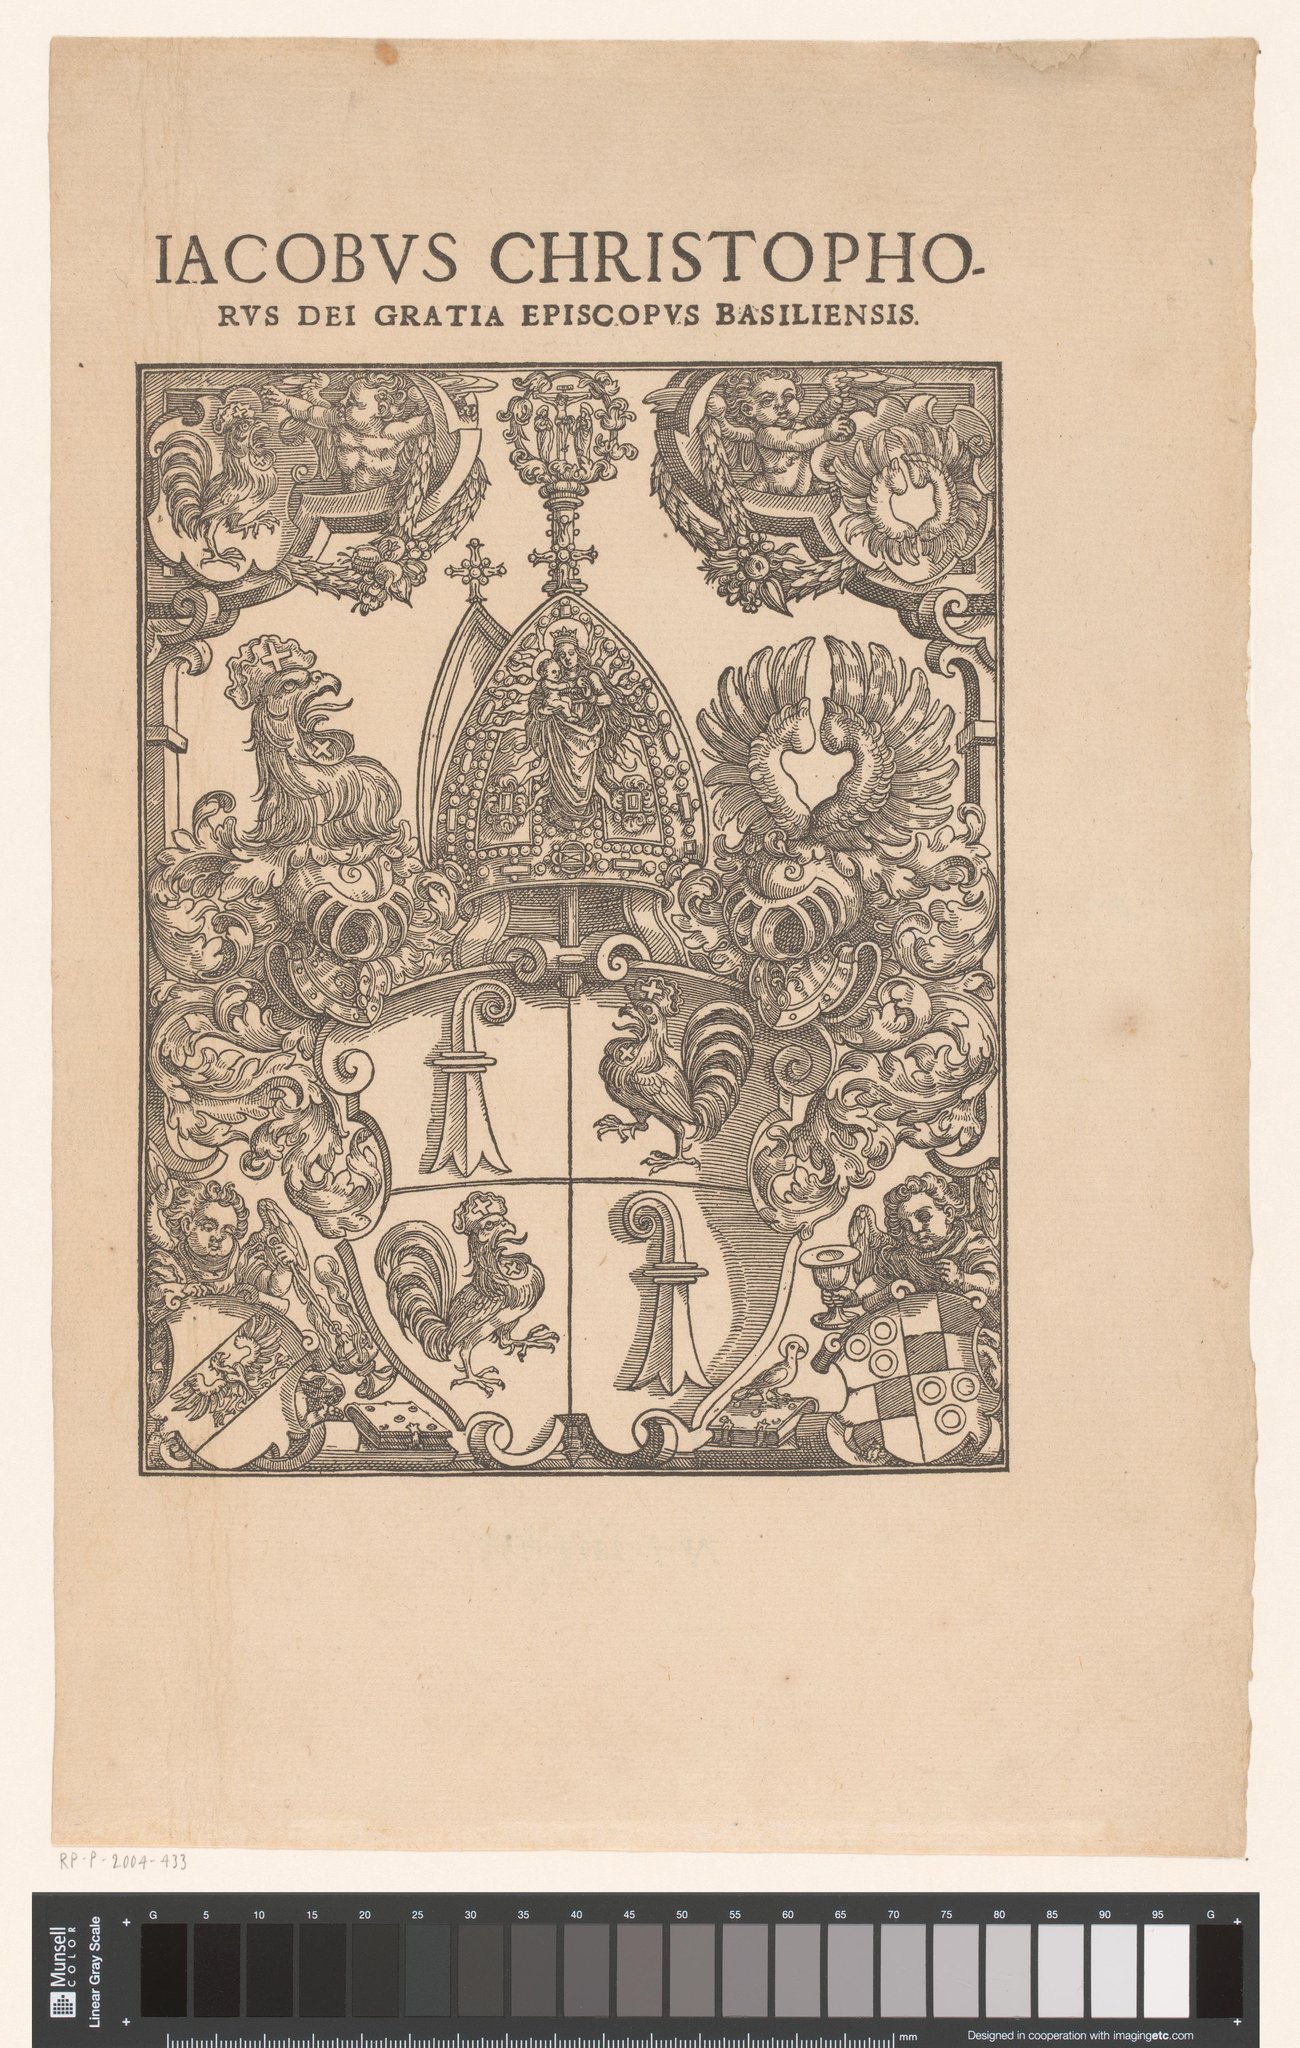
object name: print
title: Wapenschild van Jakob Christoph Blarer von Wartensee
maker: Anonymous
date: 1542-1608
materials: paper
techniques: woodcut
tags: armorial bearing, heraldry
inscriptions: collector's mark: Lugt 2760, collector's mark: Lugt 2228